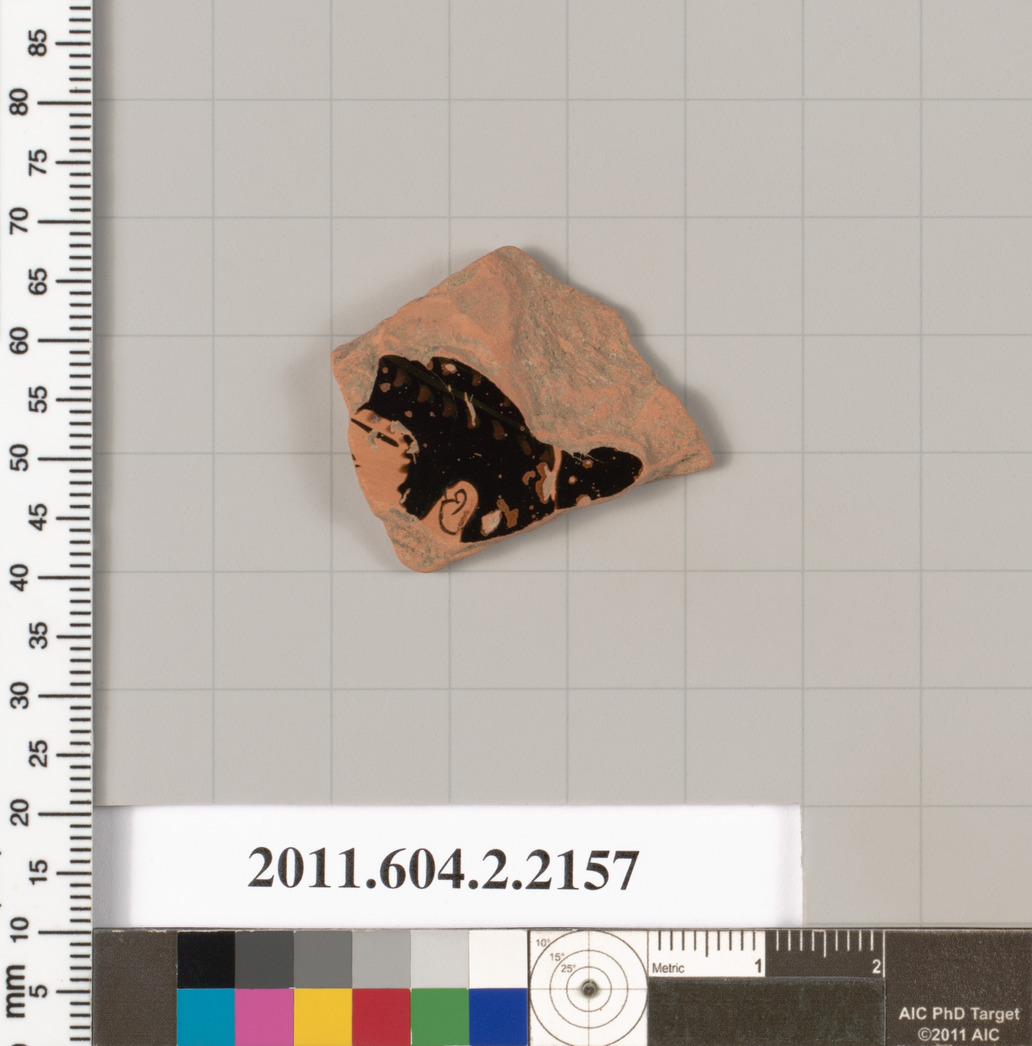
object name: pot fragment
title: Terracotta fragment of a pot; unglazed on the inside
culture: greek, attic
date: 510-490 BCE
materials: terracotta